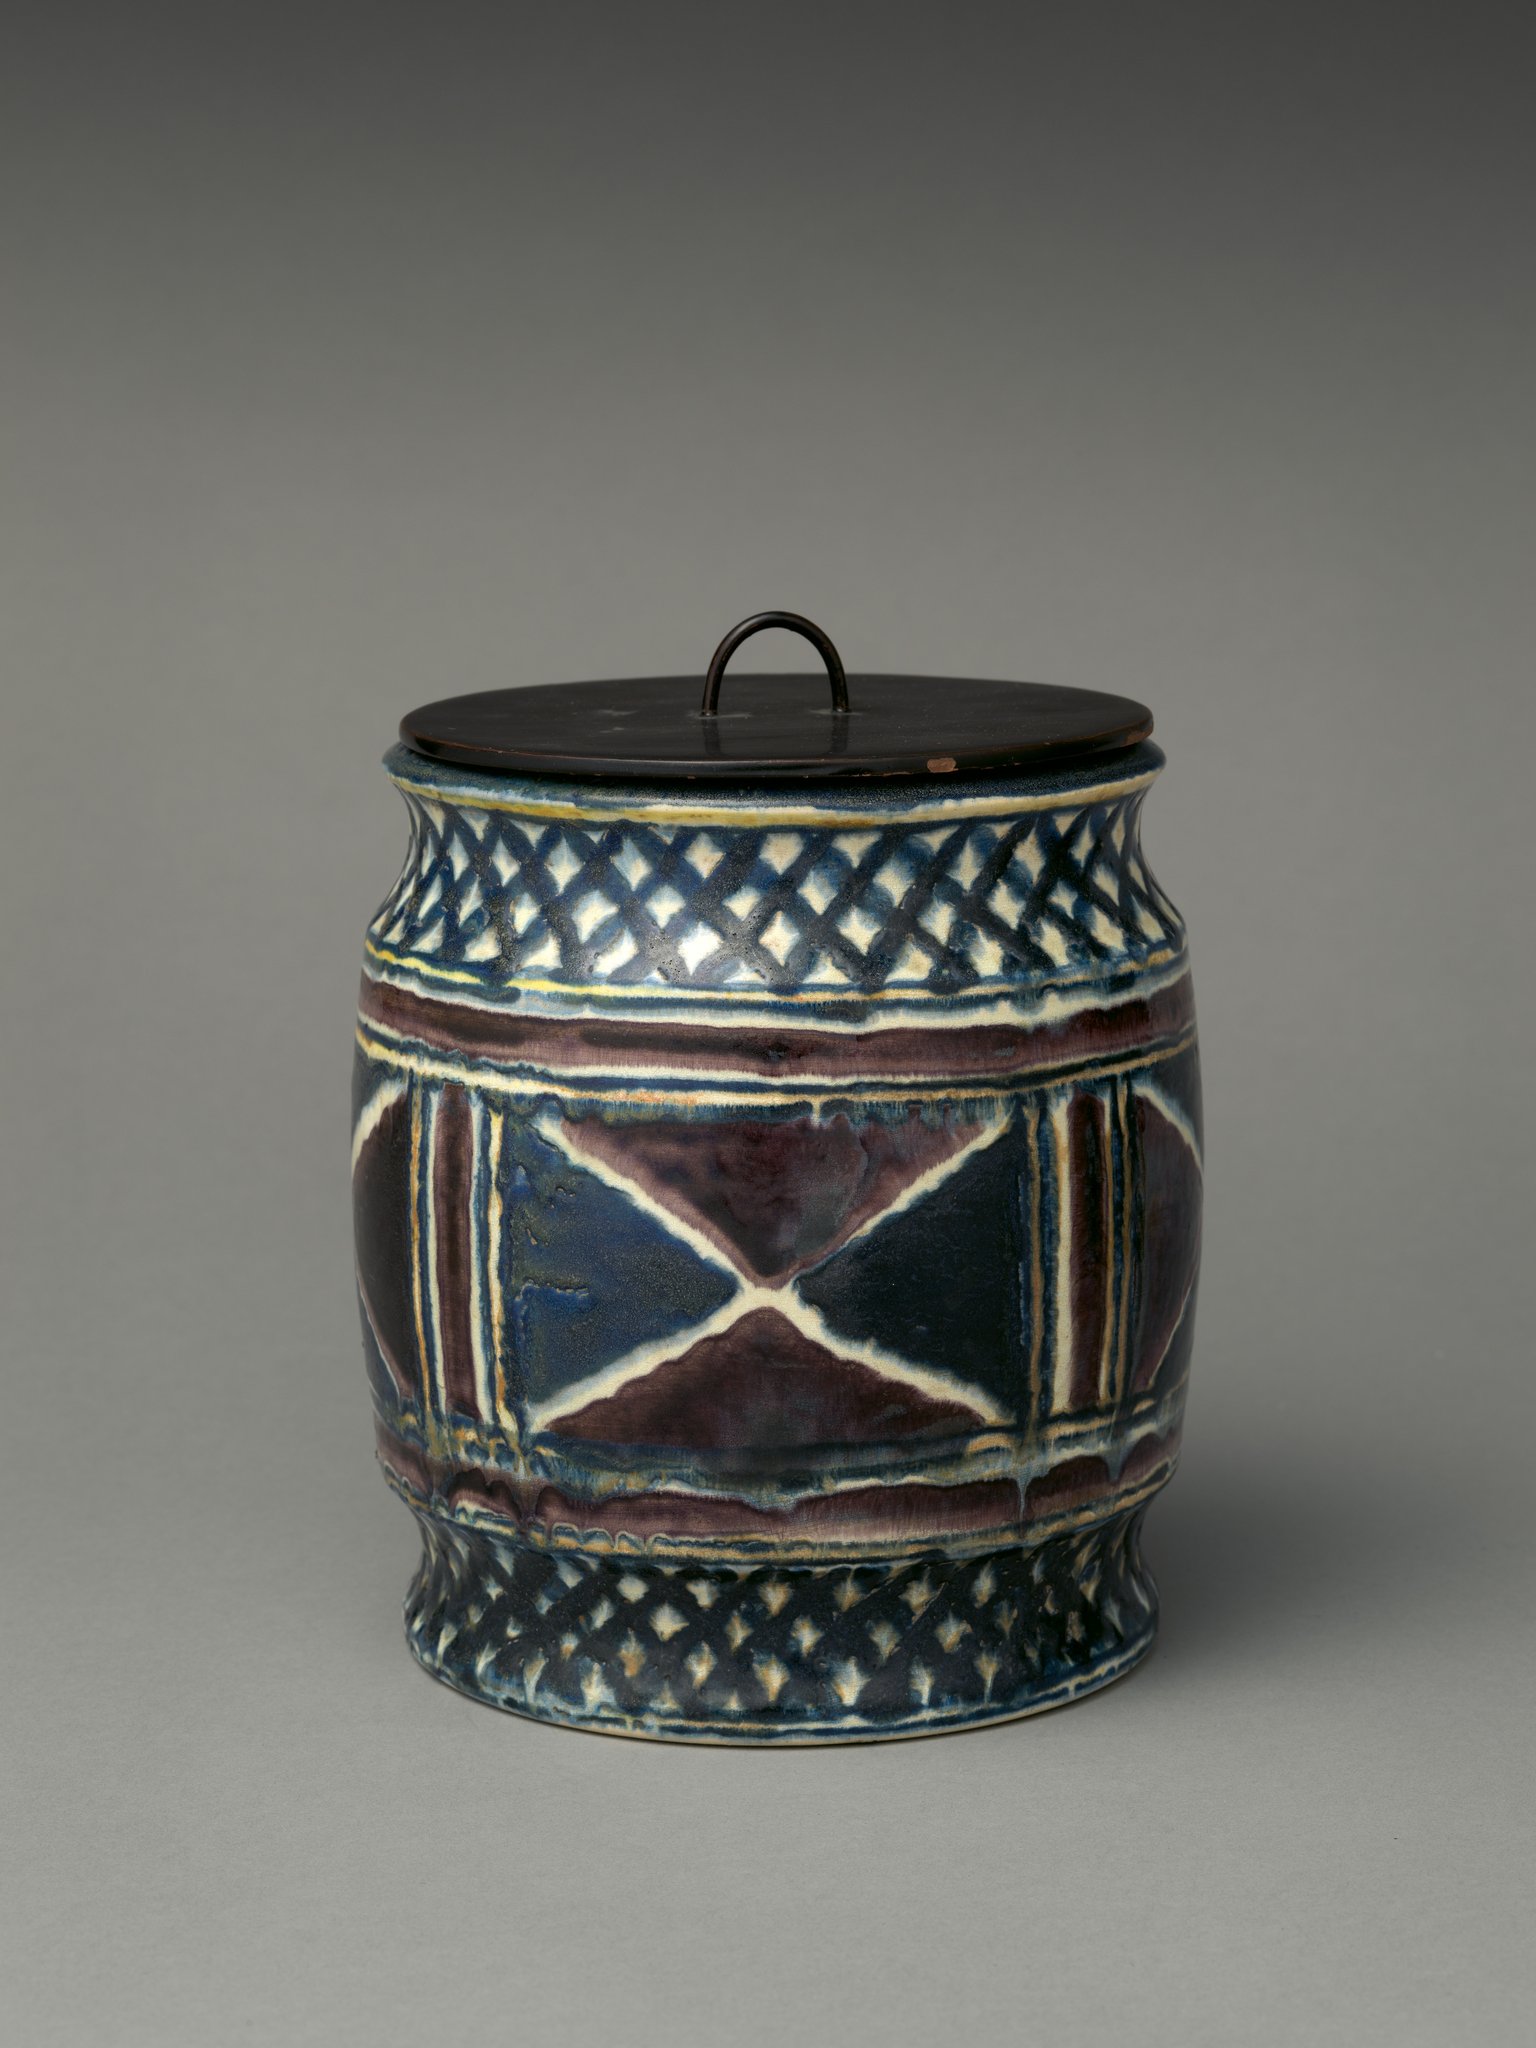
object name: freshwater jar mizusashi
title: Freshwater Jar (Mizusashi)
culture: japanese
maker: ogata ihachi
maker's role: artist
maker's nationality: japanese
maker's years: 1720-1760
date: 1701-1750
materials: lacquer, stoneware, wood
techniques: polychrome